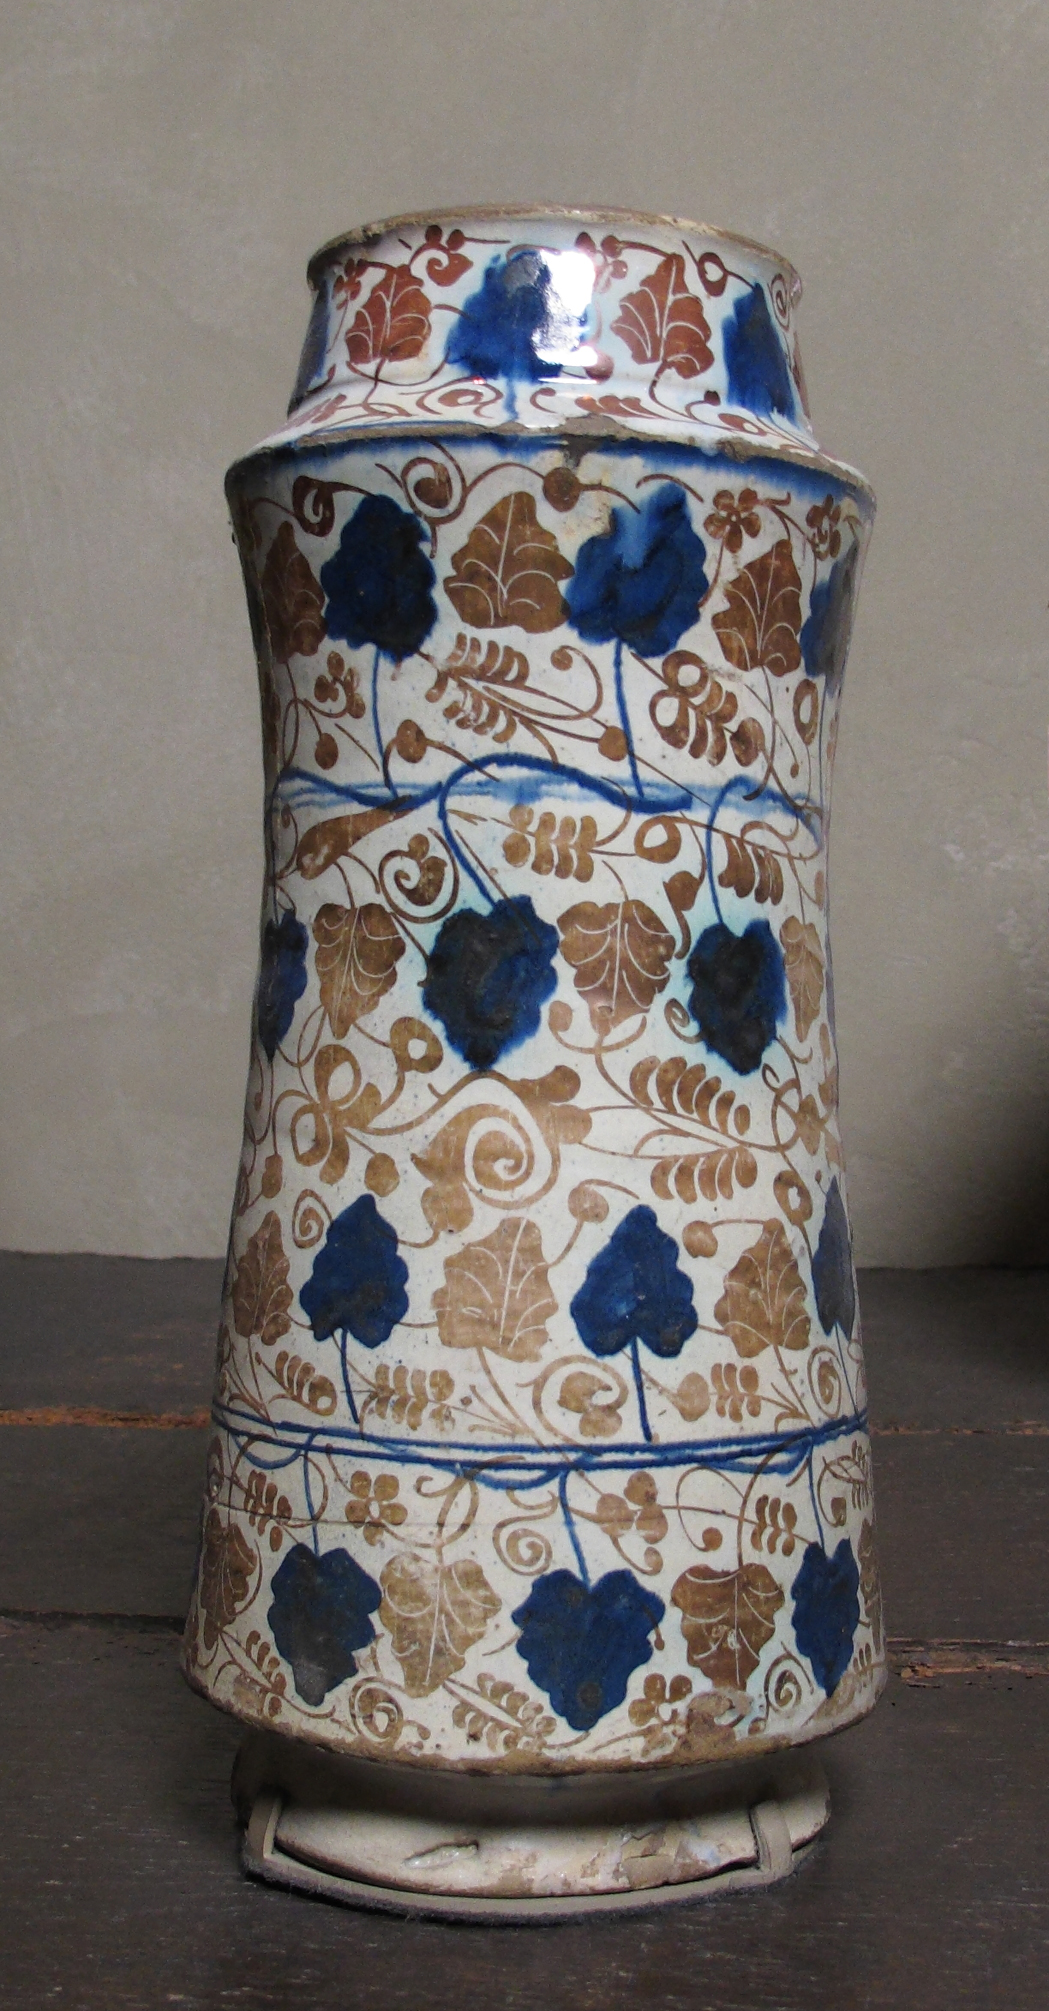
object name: pharmacy jar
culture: spanish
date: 1435-1465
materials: earthenware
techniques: glazing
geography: spain